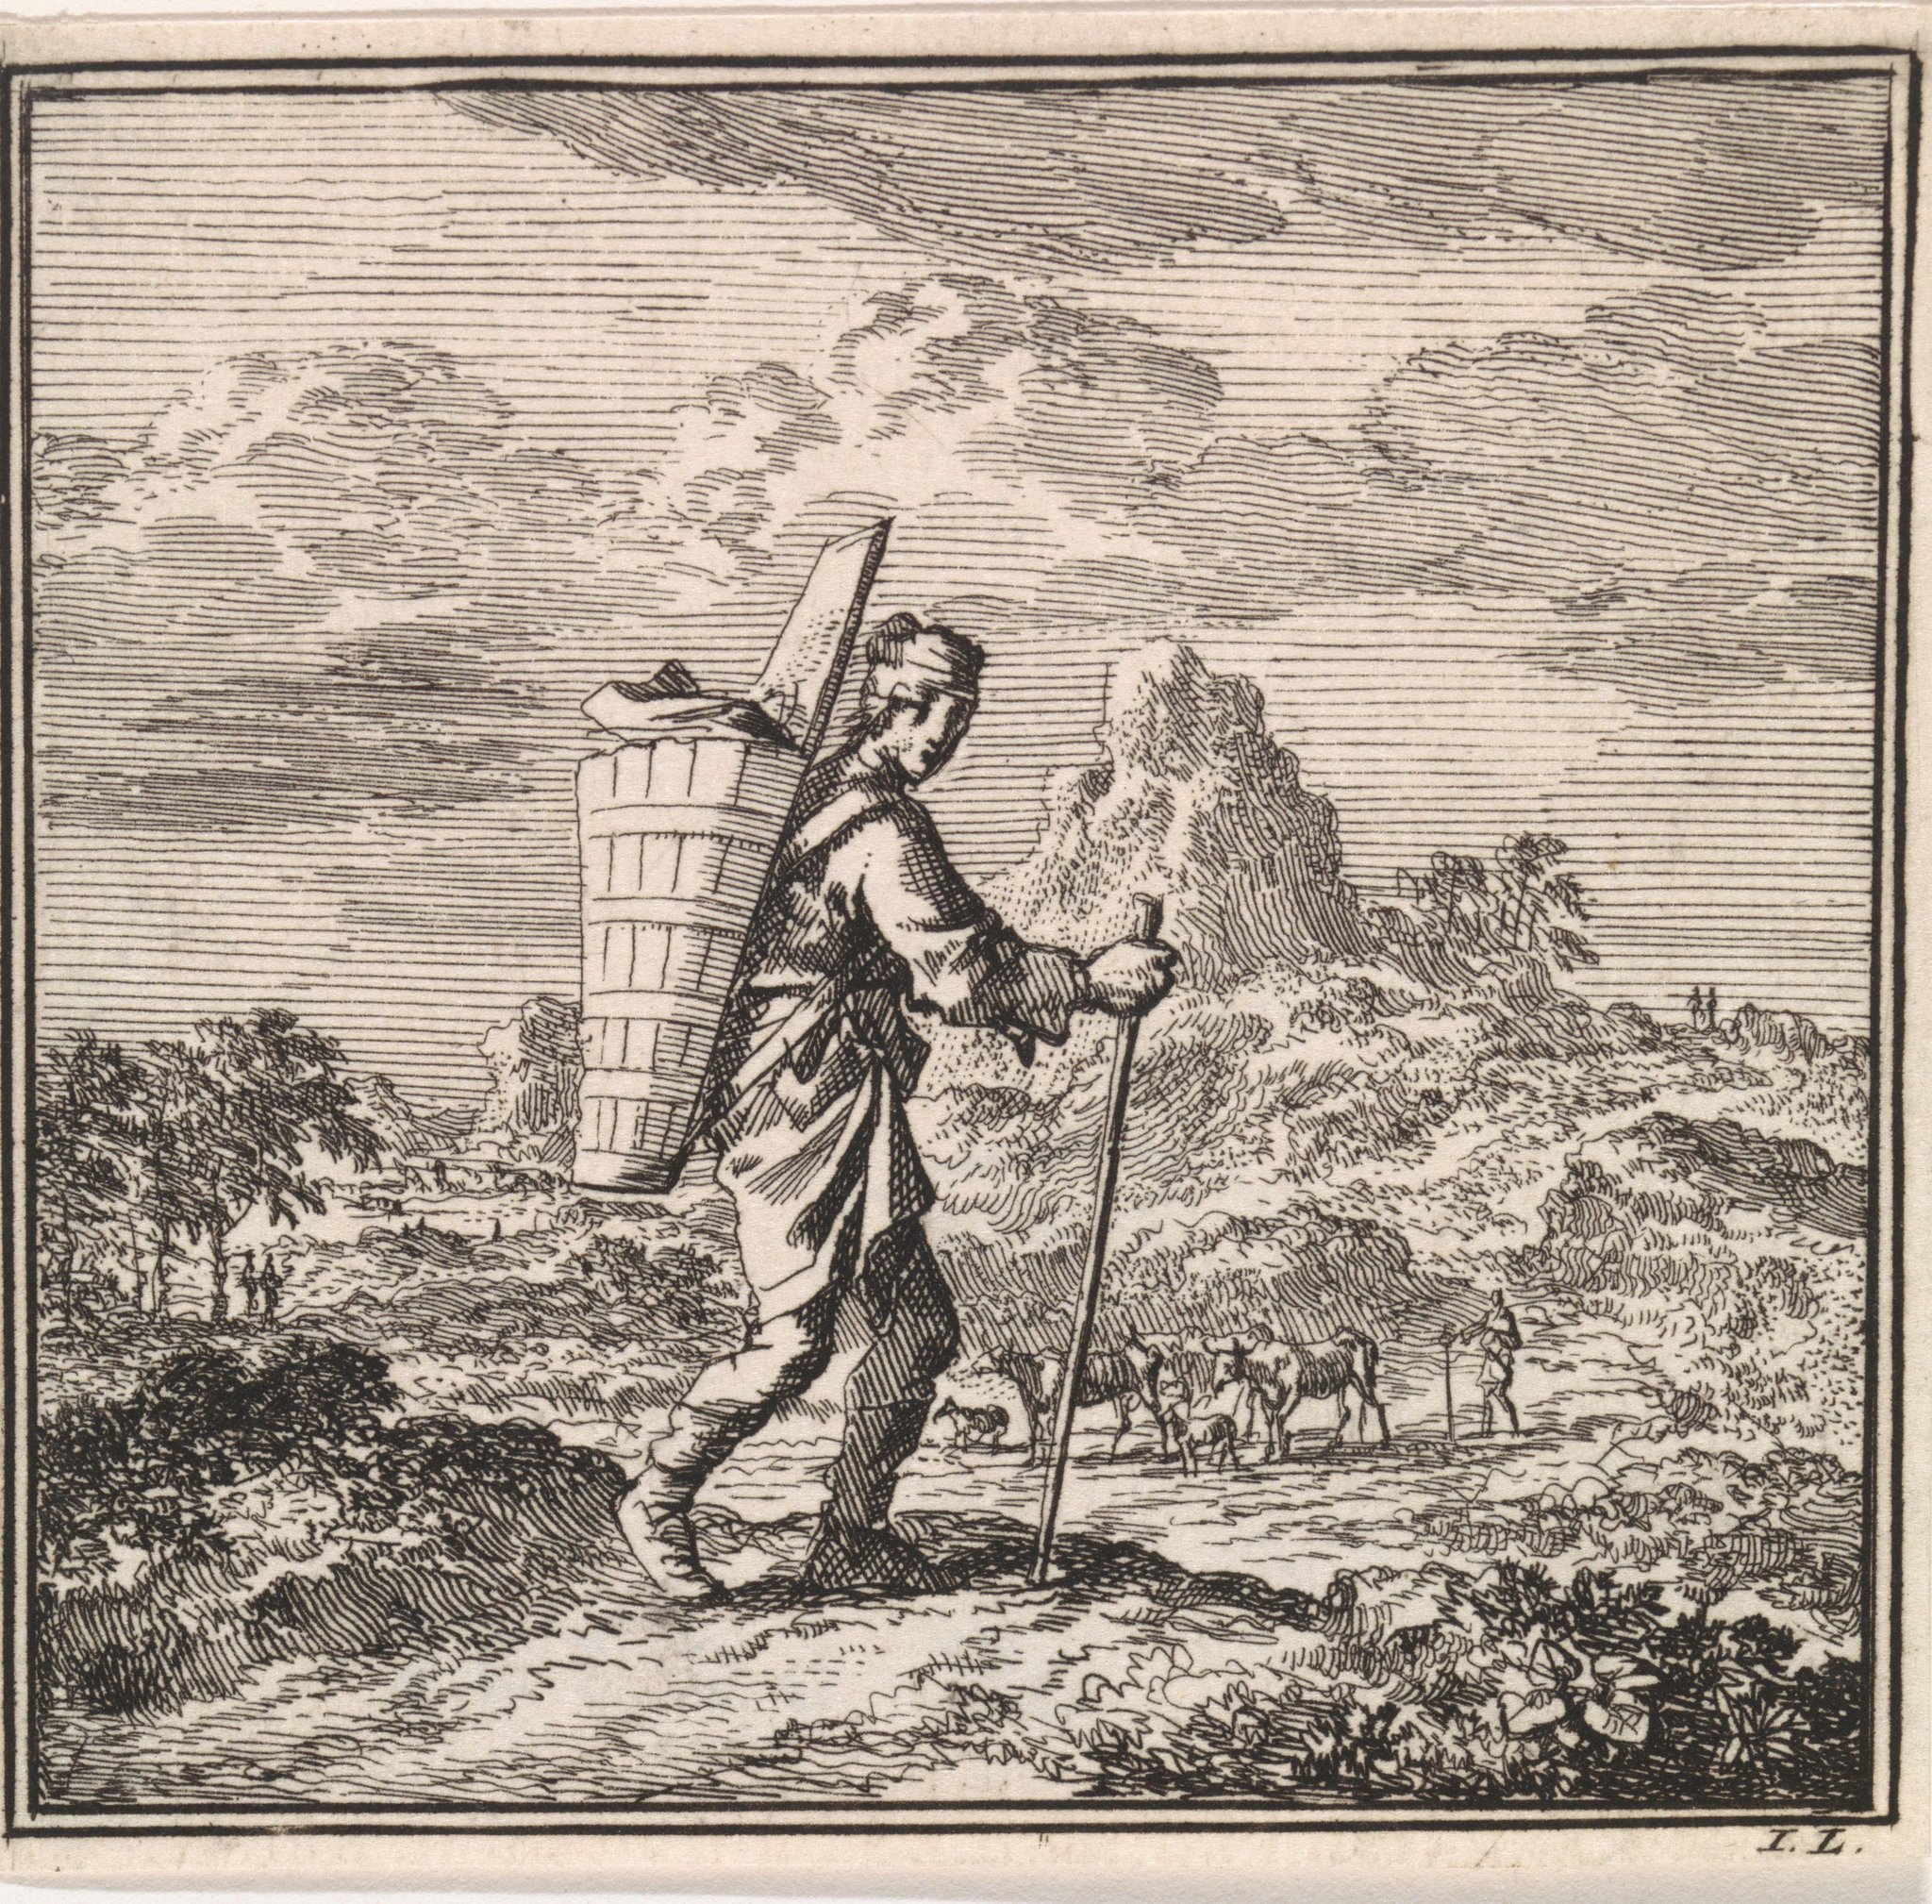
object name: print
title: De Wandelstok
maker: jan luyken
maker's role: draughtsman, print maker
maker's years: 1649-1712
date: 1711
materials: paper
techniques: etching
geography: amsterdam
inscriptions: collector's mark: Lugt 2228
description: Illustratie voor: Luyken, Jan. De Bykorf des Gemoeds. Amsterdam: Pieter Arentsz. II (wed.) en Cornelis van der Sys, 1711, p. 150.